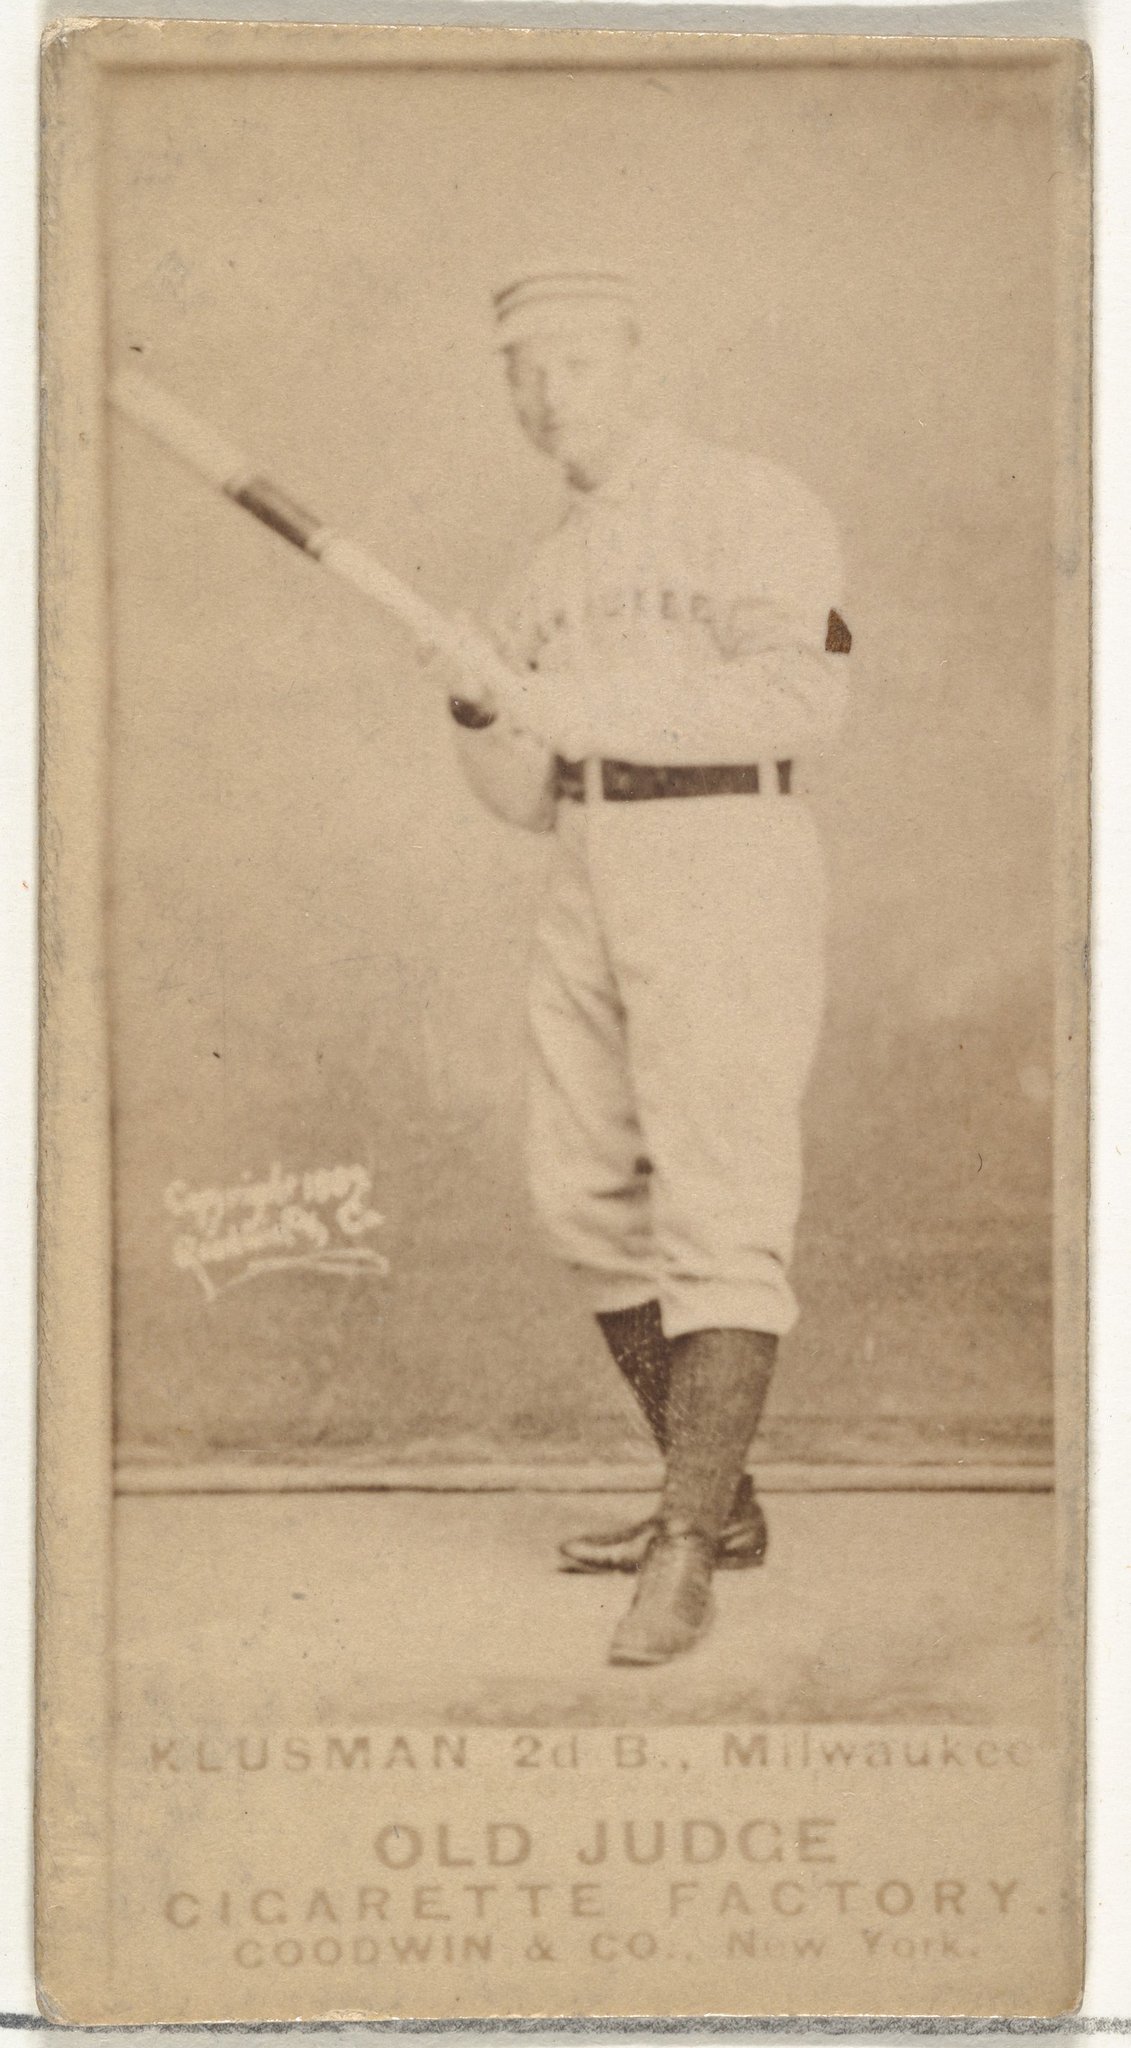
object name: baseball card, photograph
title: William F. "Billy" Klusman, 2nd Base, Milwaukee, from the Old Judge series (N172) for Old Judge Cigarettes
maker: goodwin & company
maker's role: publisher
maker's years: 1850-1950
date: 1887-1890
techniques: albumen silver print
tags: men,portraits,baseball,athletes